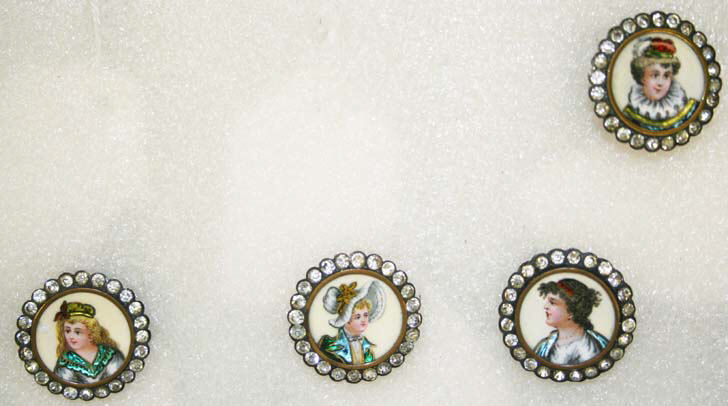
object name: button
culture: french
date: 1880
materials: enamel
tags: men,portraits,women